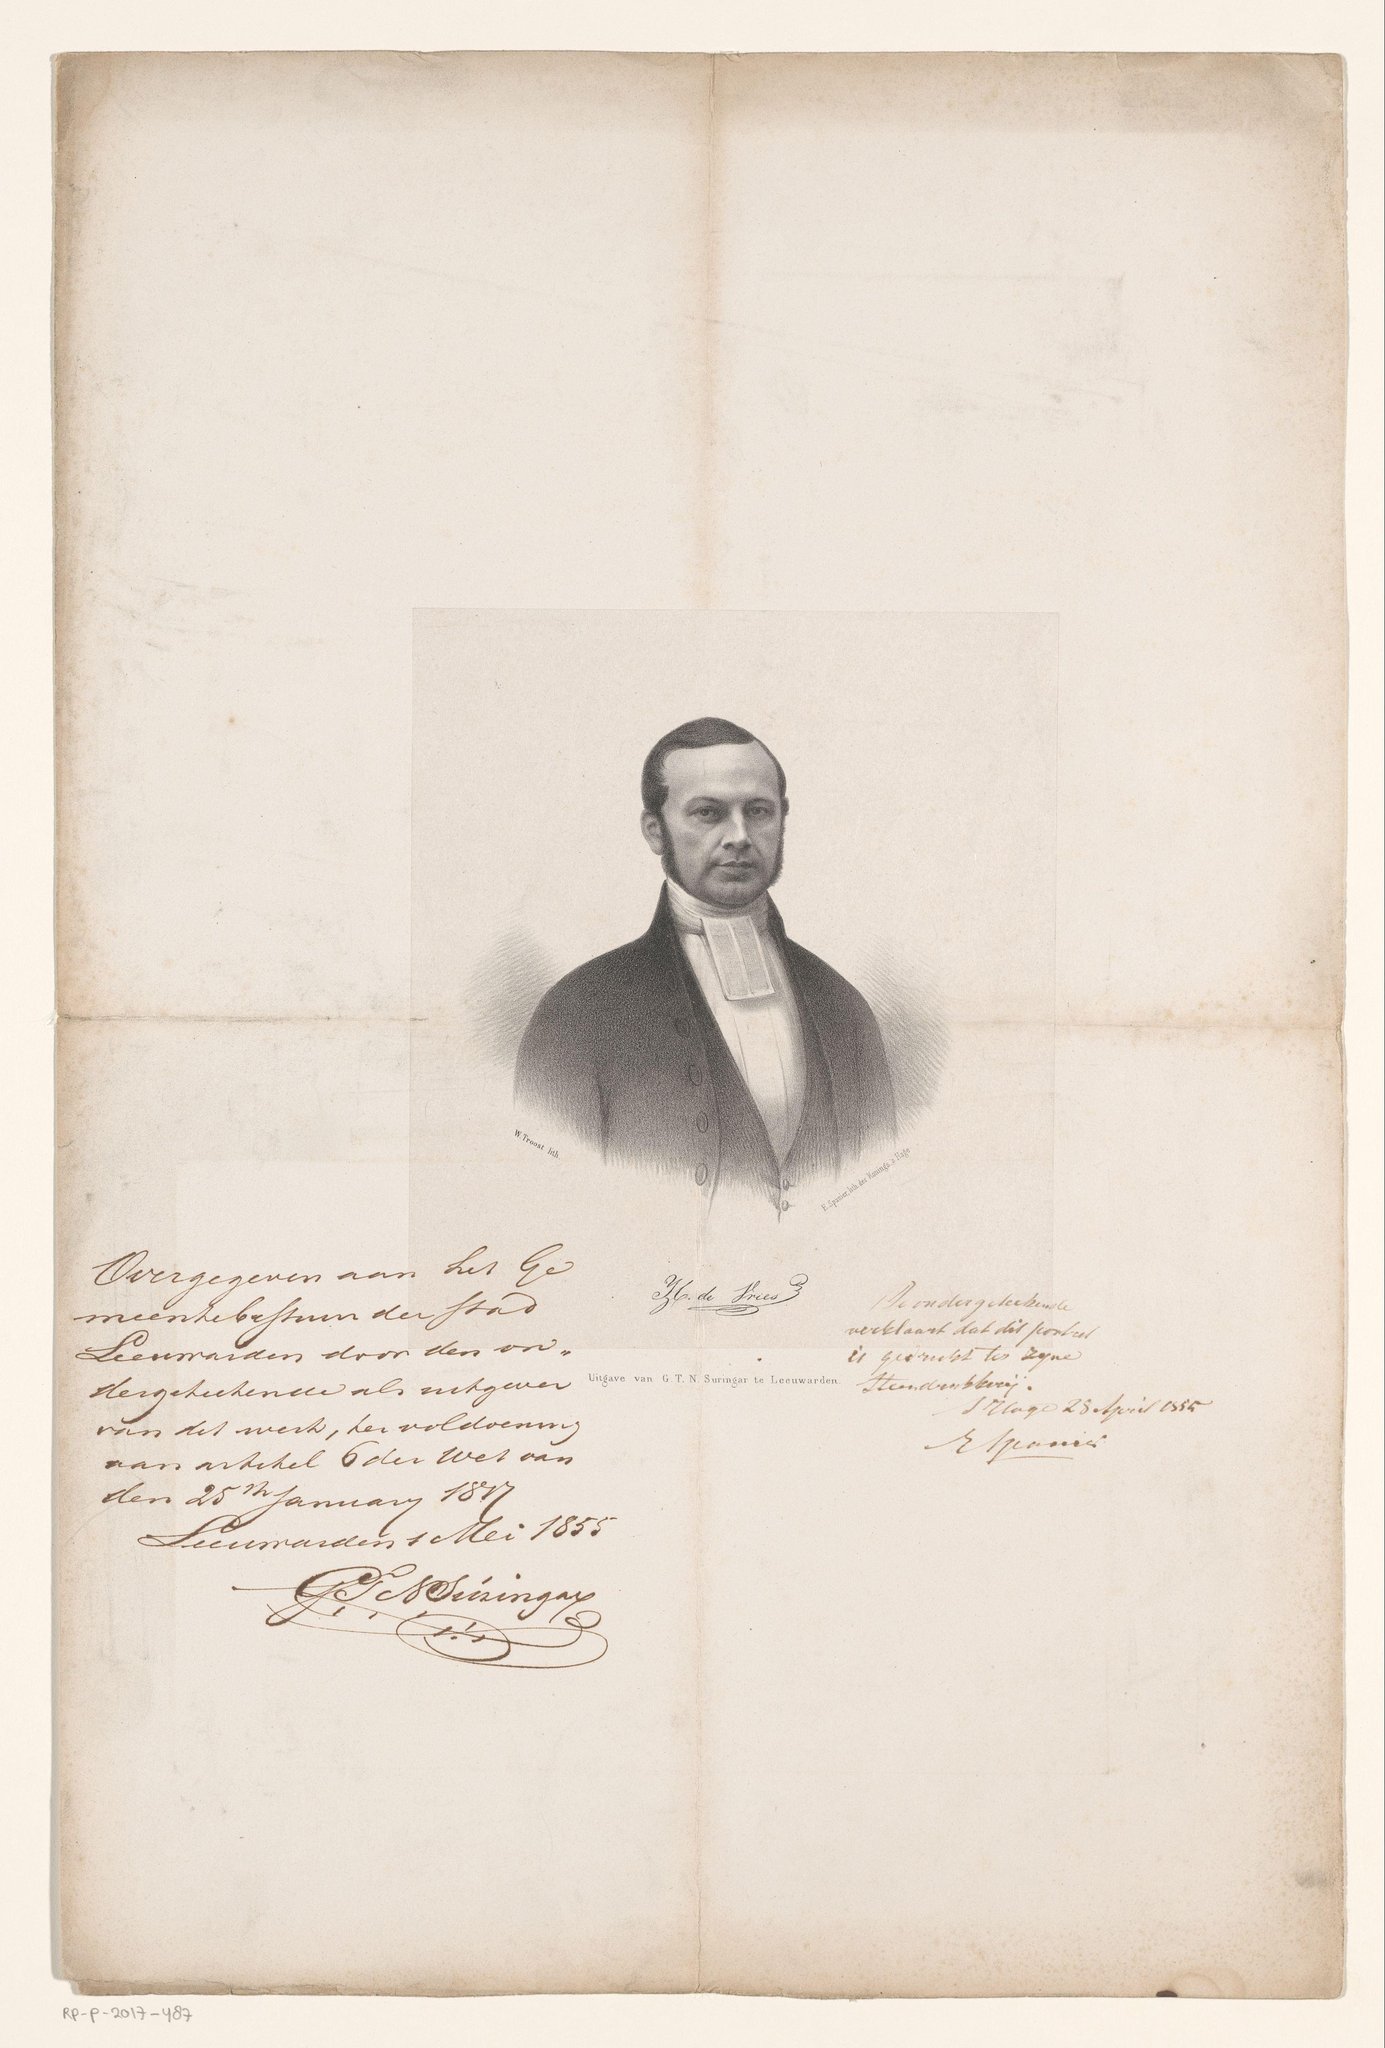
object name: print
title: Portret van M. de Vries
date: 1855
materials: paper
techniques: lithograph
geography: leeuwarden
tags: historical persons (+ (full) bust portrait)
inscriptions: stamp, : ‘De ondergeteekende / verklaart dat dit portret / is gedrukt ter zijne / steendrukkerij. / S Hage 28 april 1855 / E Spanier’, : ‘Overgegeven aan het ge / meentebestuur der stad / Leeuwarden door den on / dergeteekende als uitgever / van dit werk, ter voldoening / aan artikel 6 der wet van / den 25ste january 1817 / Leeuwarden 1 mei 1855 / GTNSuringar’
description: Onder het portret de signatuur van de geportretteerde.